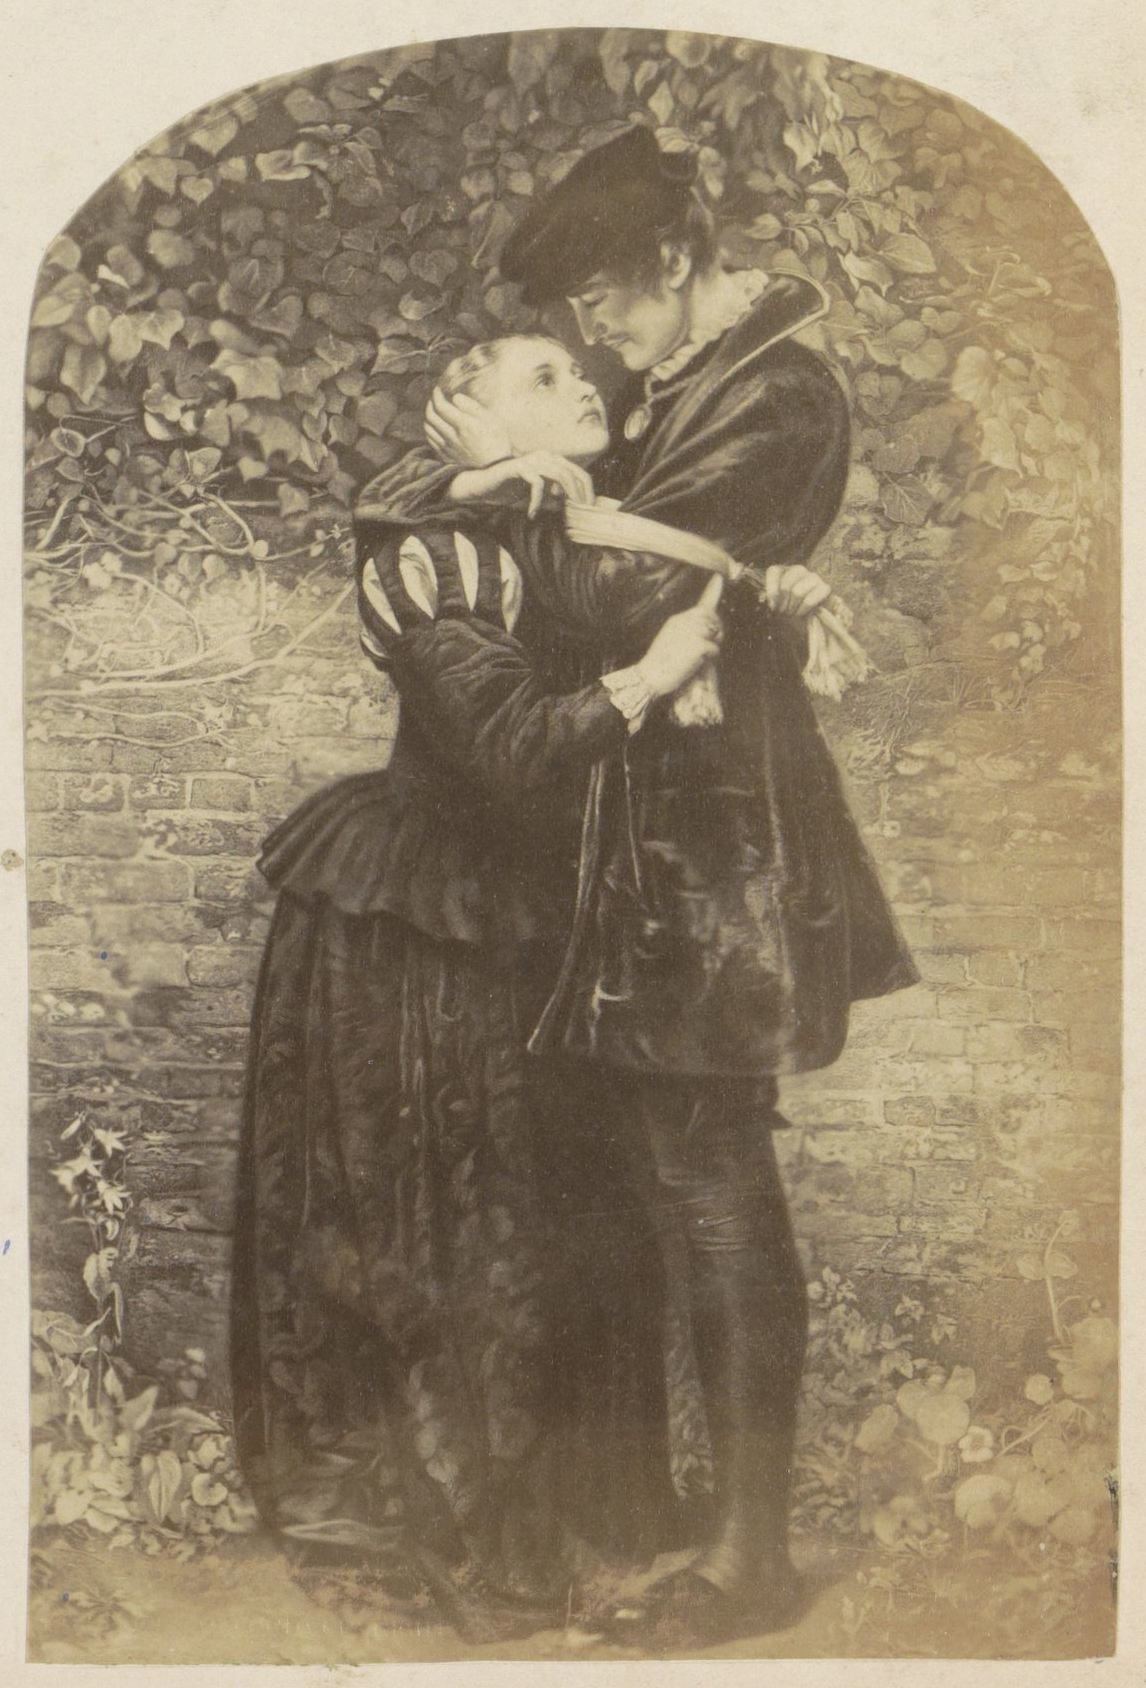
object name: reproduction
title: Fotoreproductie van een schilderij van John Everett Millais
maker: Anonymous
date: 1850-1870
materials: paper, photographic support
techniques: albumen print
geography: england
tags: persecuted believers (hiding), e.g. huguenots, pilgrim fathers, couple of lovers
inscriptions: check stamp: ‘[...]’, check stamp: ‘B. Brooks Oxford Copyright’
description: Onderdeel van Album met foto's van bezienswaardigheden en landschappen in Engeland en van kunst.